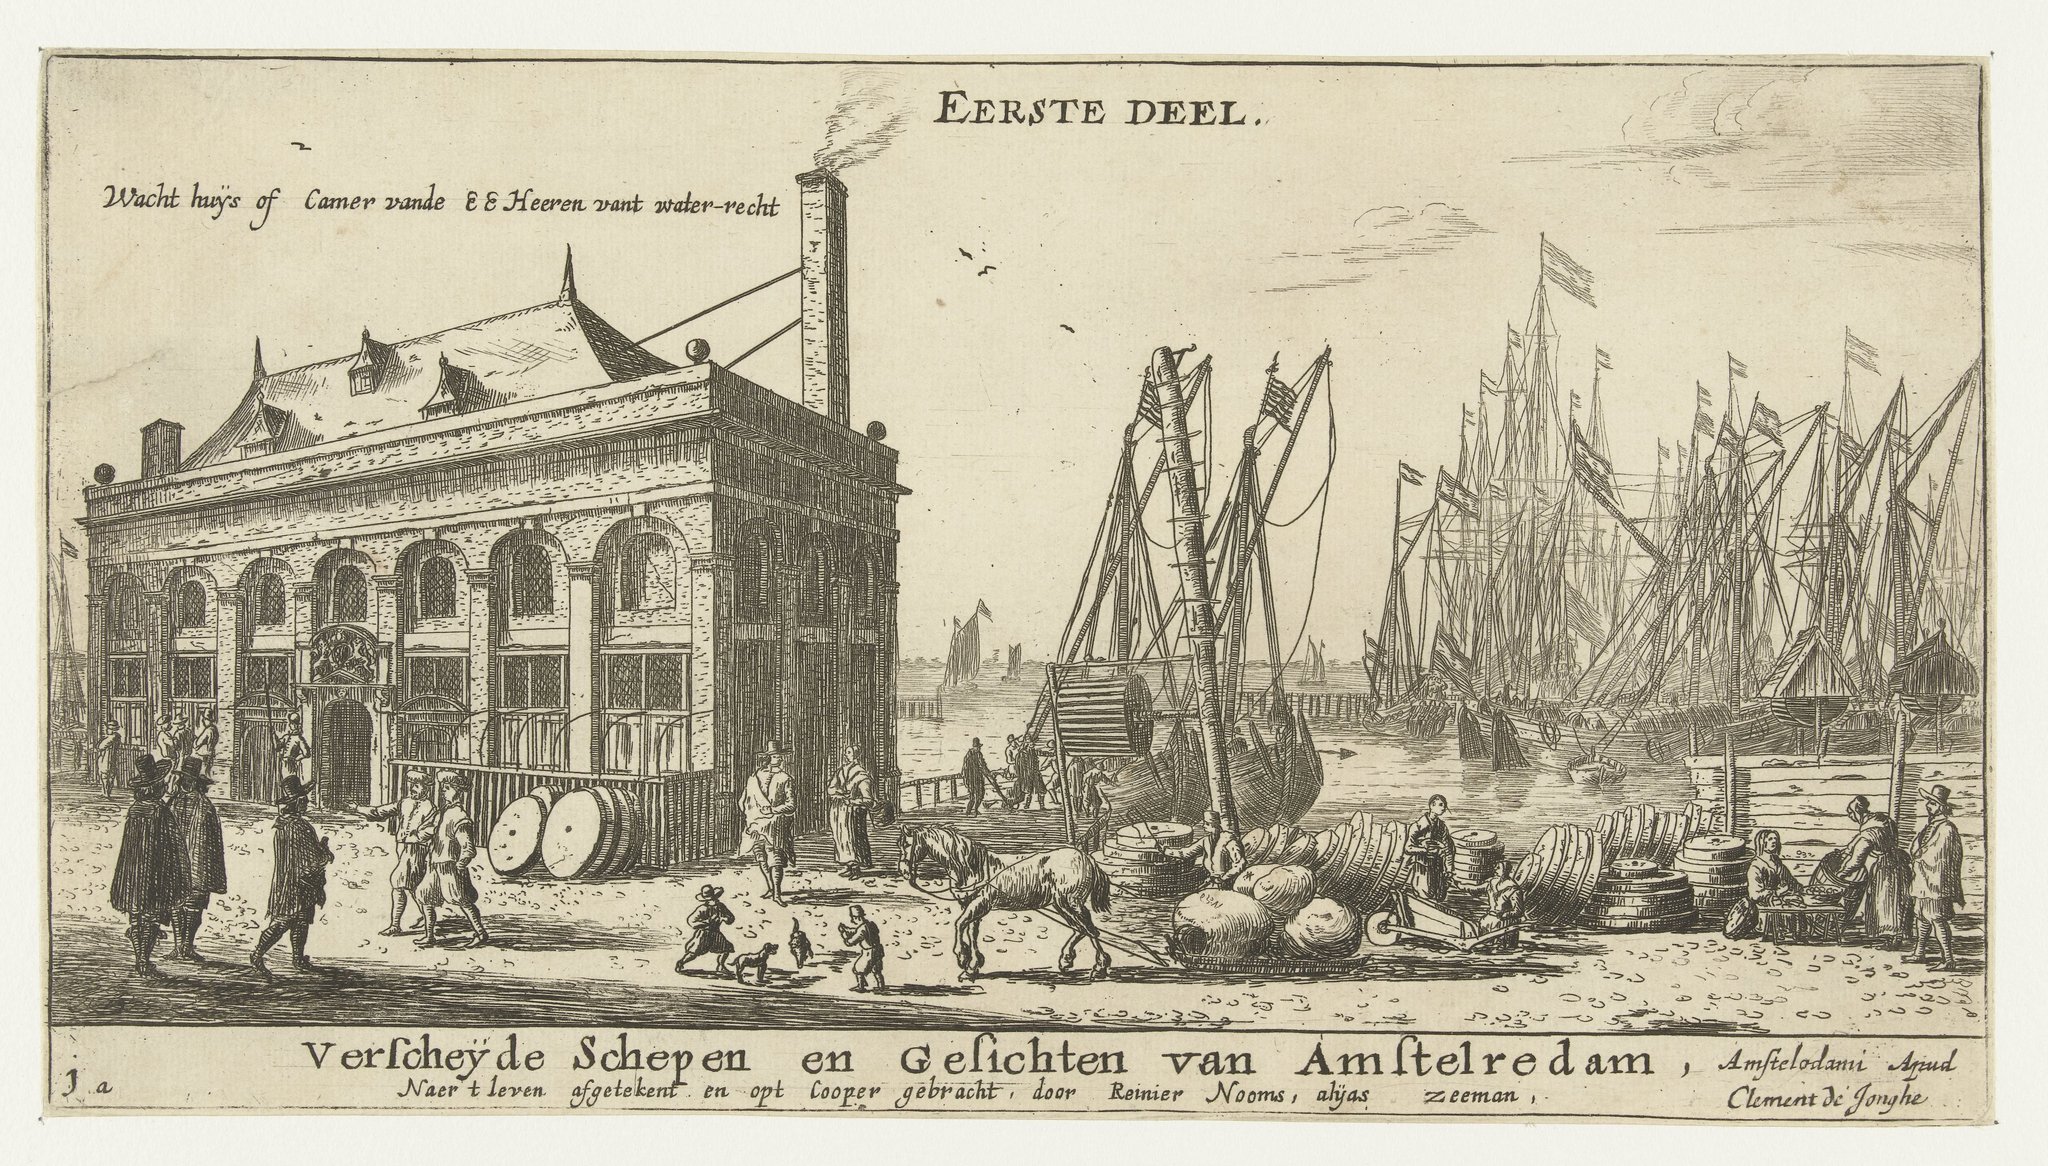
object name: print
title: Eerste deel. Verscheÿde schepen en gesichten van Amstelredam, naer t leven afgetekent en opt cooper gebracht, door Reinier Nooms, alÿas Zeeman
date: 1652-1670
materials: paper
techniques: drypoint, etching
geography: netherlands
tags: harbour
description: Titelblad van een serie schepen en stadsgezichten. De kamer van de heren van het waterrecht op het Kamperhoofd en de Slijpstenenmarkt bij de haven. Rechts liggen de slijpstenen op de kade, daar achter zeilschepen. Tegenwoordig de Prins Hendrikkade.